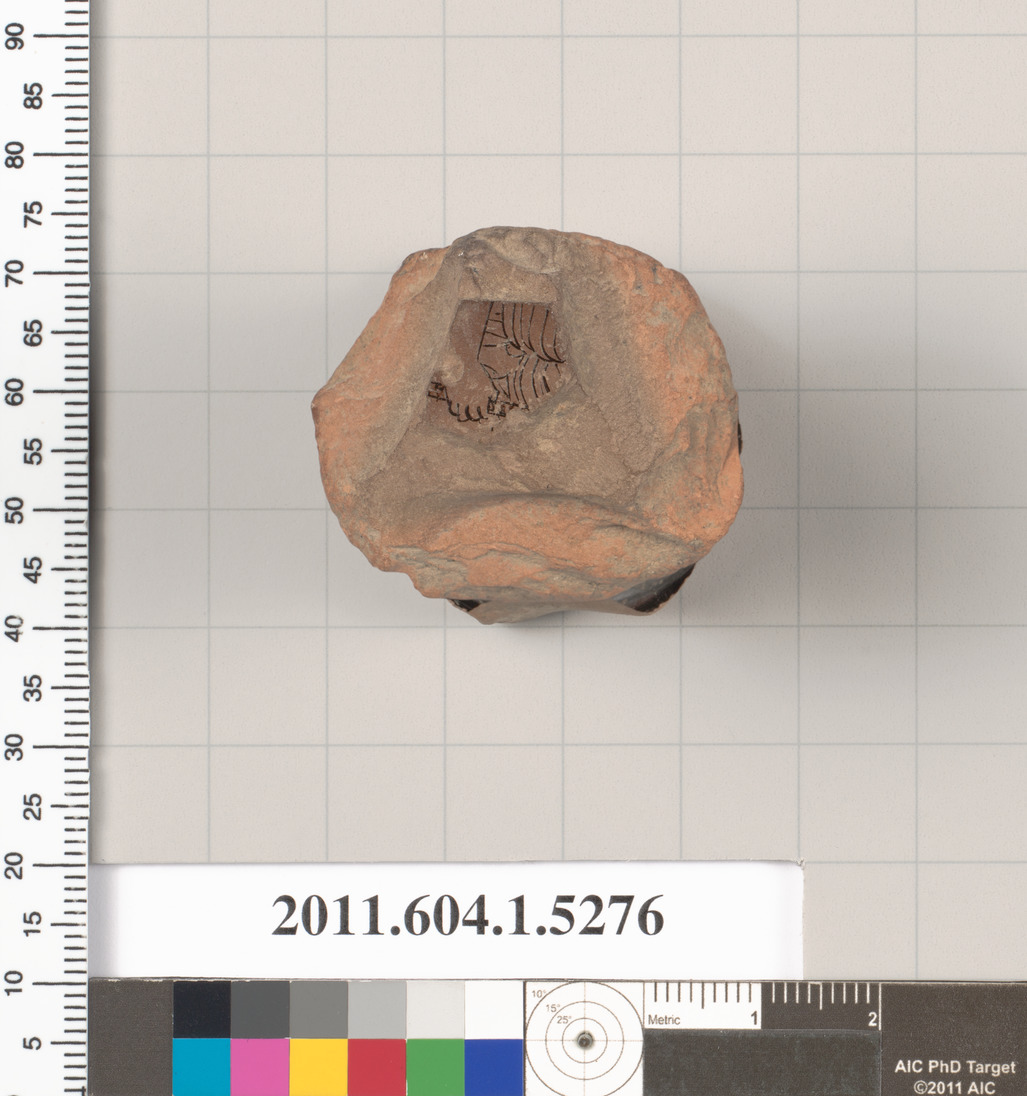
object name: kylix fragment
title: Terracotta fragment of a kylix (drinking cup)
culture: greek, attic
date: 490-470 BCE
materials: terracotta